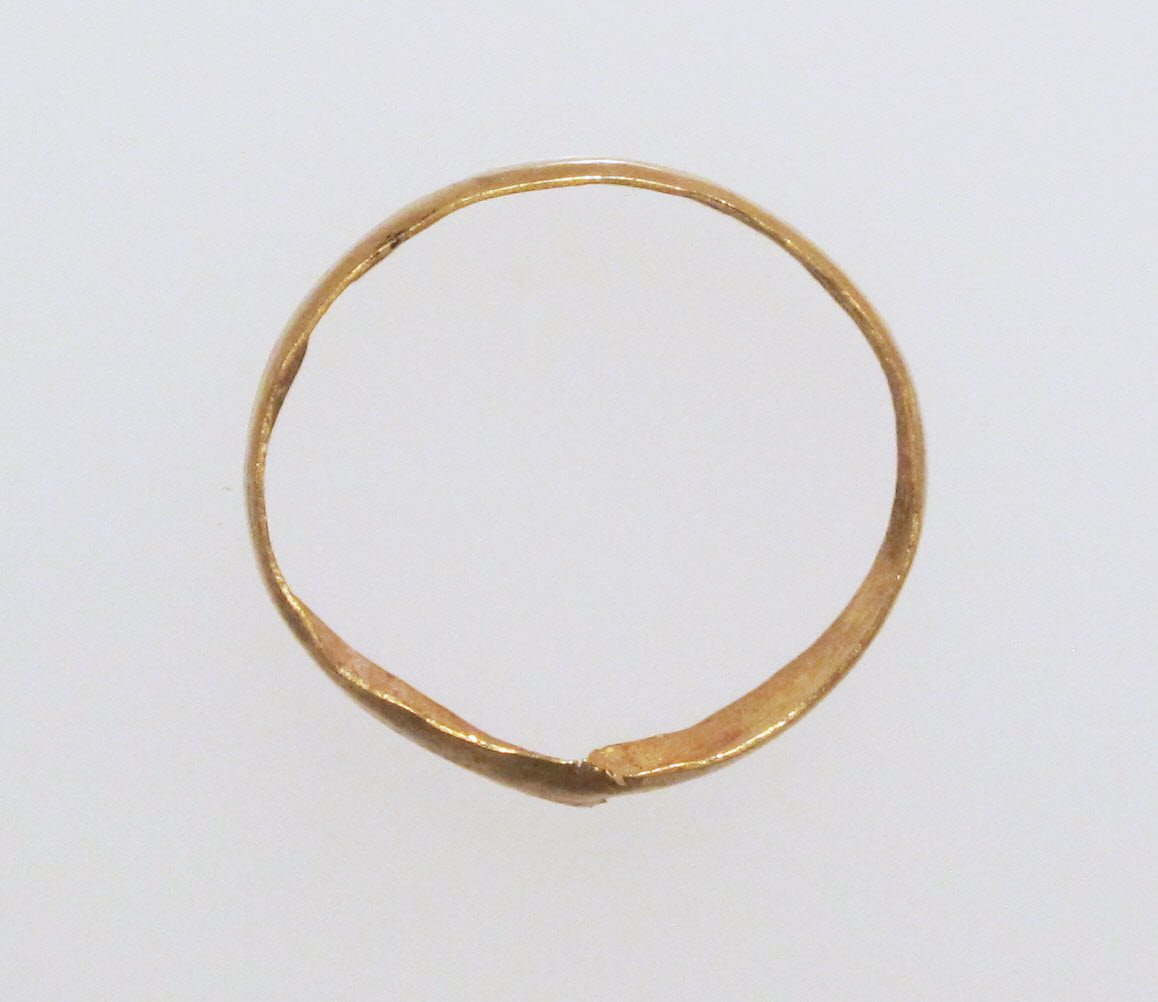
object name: ring with hollow hoop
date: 7000 BCE-330 CE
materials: gold